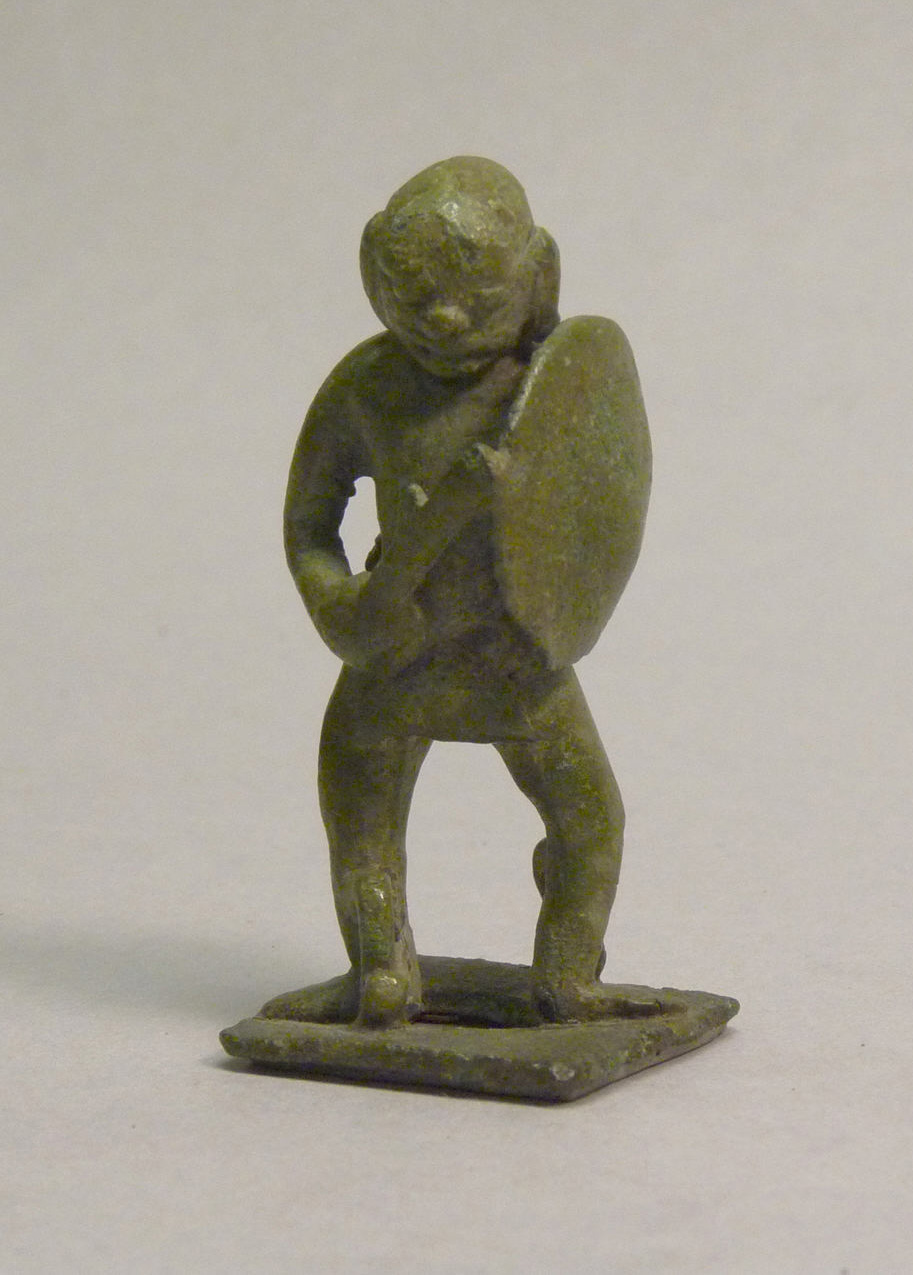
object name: standing warrior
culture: indonesian, javanese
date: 500 BCE-300 CE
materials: bronze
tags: men